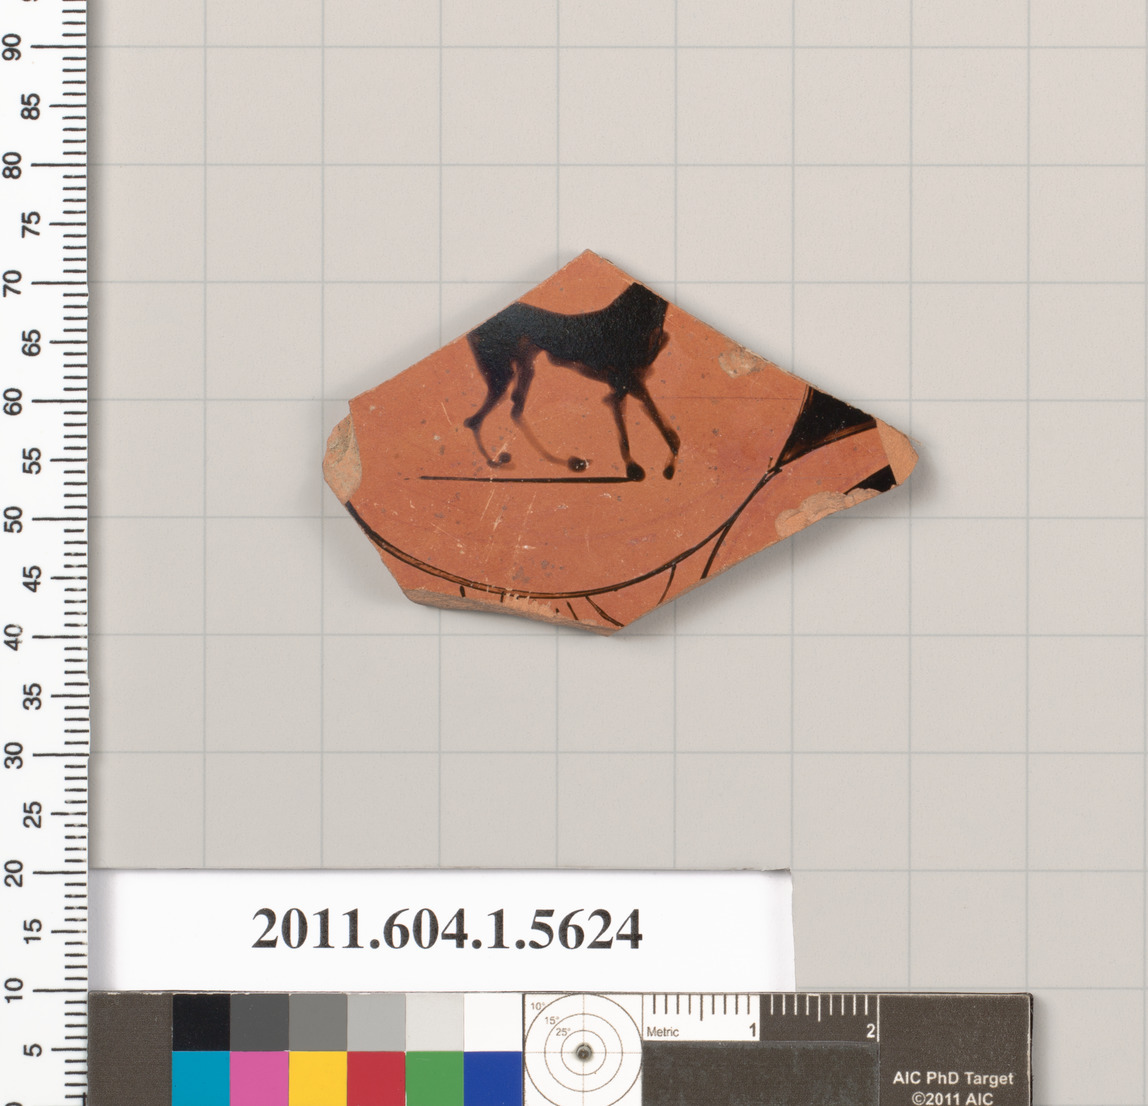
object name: kylix fragment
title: Terracotta fragment of a kylix (drinking cup)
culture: greek, attic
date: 520-500 BCE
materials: terracotta